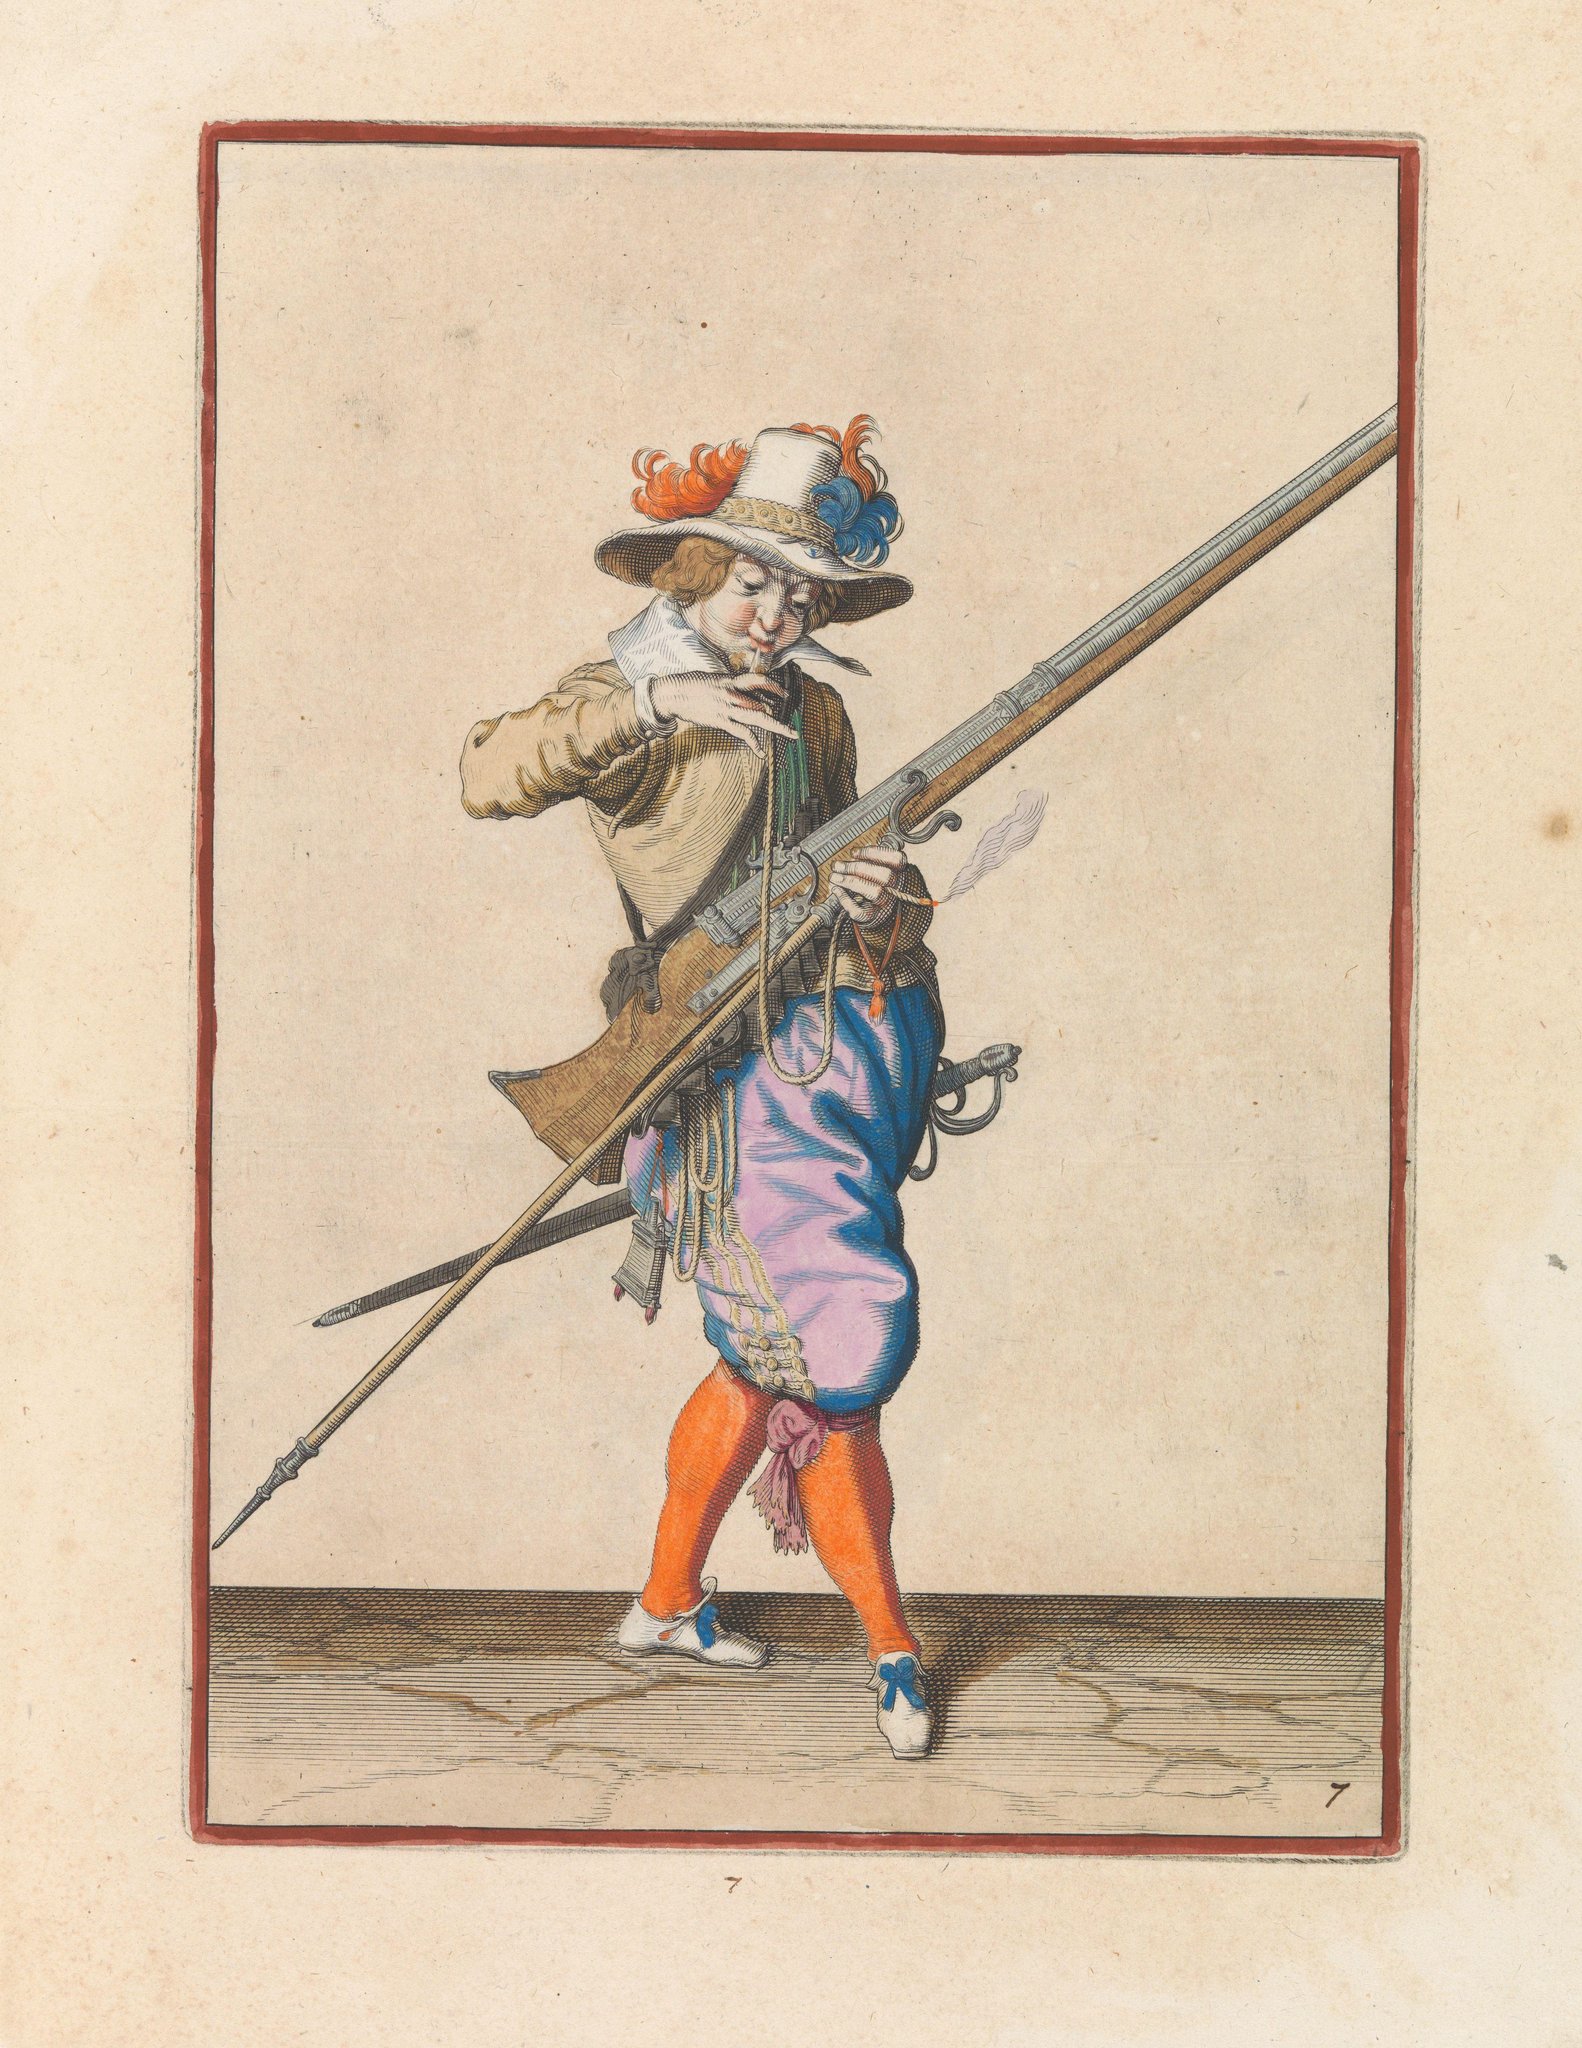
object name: print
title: Soldaat met een musket die zijn lont naar zijn mond brengt om hem schoon te blazen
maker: jacques de gheyn (ii)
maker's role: painter, print maker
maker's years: 1565-1629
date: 1597-1607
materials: paper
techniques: engraving, hand coloring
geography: the hague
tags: handling of weapons ~ military training, firearms: rifle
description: Een soldaat, ten voeten uit, naar rechts, die een musket (een bepaald type vuurwapen) met zijn linkerhand vasthoudt. Met zijn rechterhand brengt hij een brandende lont naar zijn mond om hem schoon te blazen. Deze prent is onderdeel van de reeks van 43 met de hand genummerde prenten van musketiers in de Wapenhandelinghe.